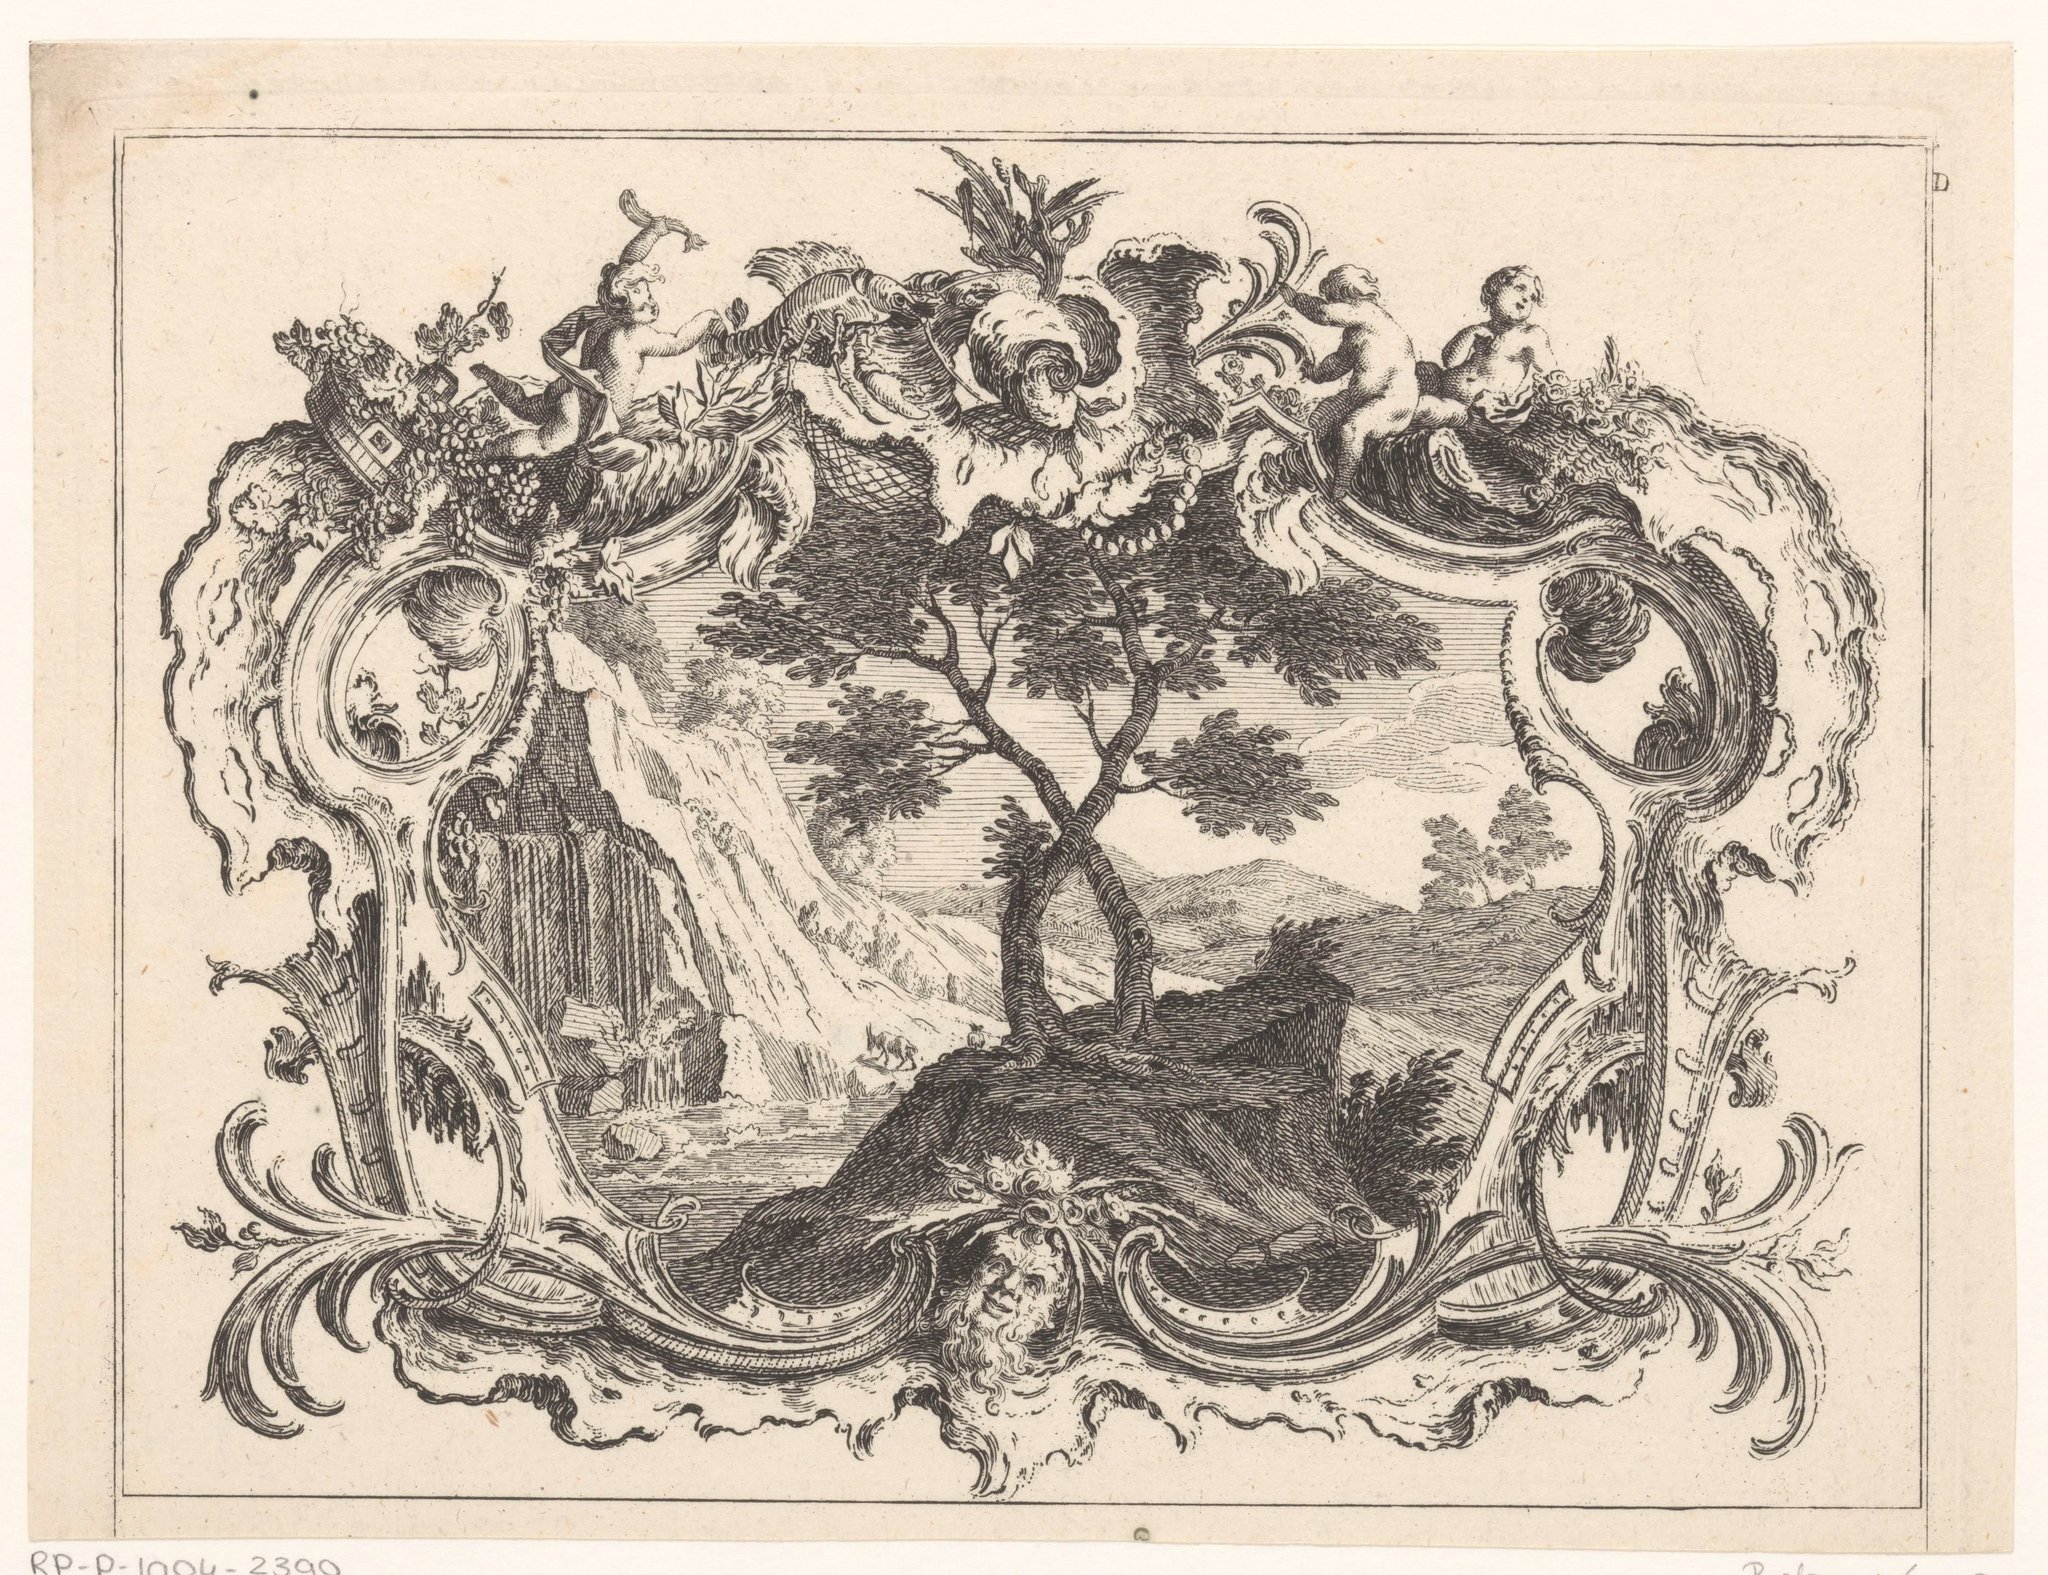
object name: ornament print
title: 4 D Morceaux de Caprices à divers usages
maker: carl albert von lespilliez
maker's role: print maker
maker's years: 1723-1796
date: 1745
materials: paper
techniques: etching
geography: germany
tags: landscapes, waterfall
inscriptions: collector's mark: Lugt 2228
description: Een landschap met op de voorgrond twee bomen en links een waterval. Rondom de voorstelling een omlijsting met putti.